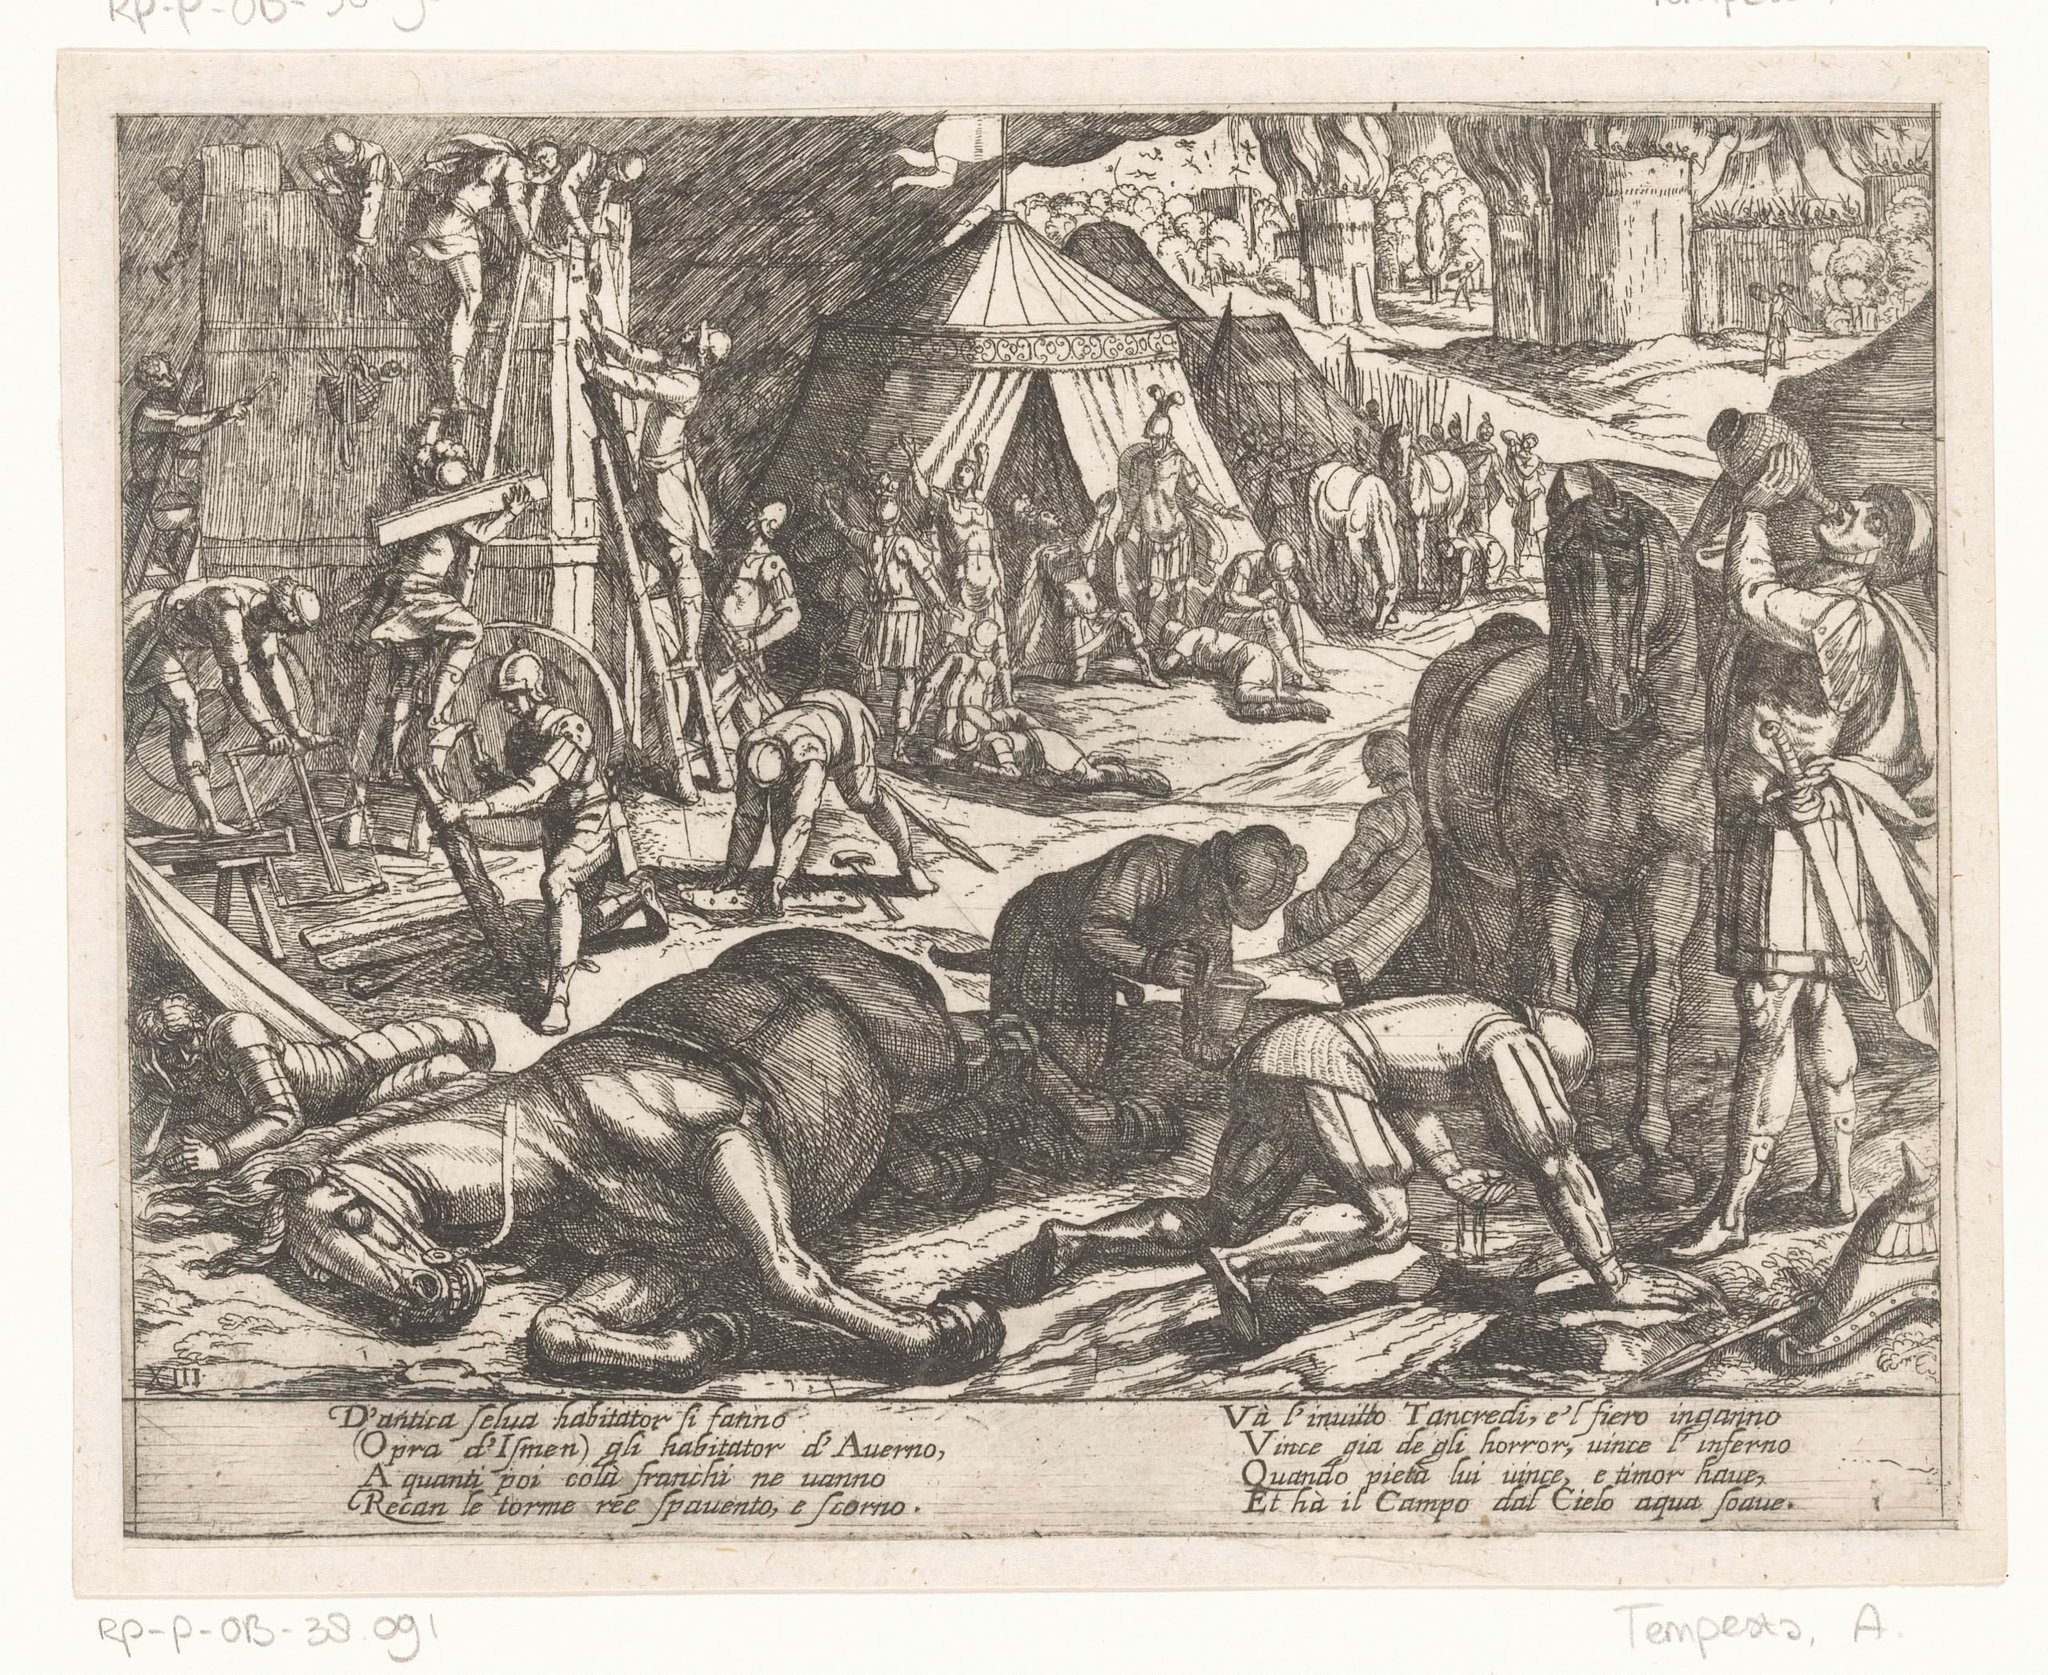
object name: print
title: Jeruzalem verlost (deel 2)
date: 1565-1630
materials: paper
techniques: etching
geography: italy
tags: militant proselytizing: religious war, crusade, etc., (scenes from) specific works of literature: tasso, gerusalemme liberata, knight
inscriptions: collector's mark: Lugt 240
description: Deze prent maakt deel uit van een reeks van twintig prenten (+ opdracht) met voorstellingen van scènes uit Tasso's 'Jeruzalem verlost', een episch gedicht geschreven door de Italiaanse dichter Torquato Tasso en voor het eerst gepubliceerd in 1581. Het verhaal vertelt grotendeels in fictie over de Eerste Kruistocht waarin de christenen, geleid door Godfried van Bouillon, de strijd aangaan met de moslims om het Beleg van Jeruzalem.